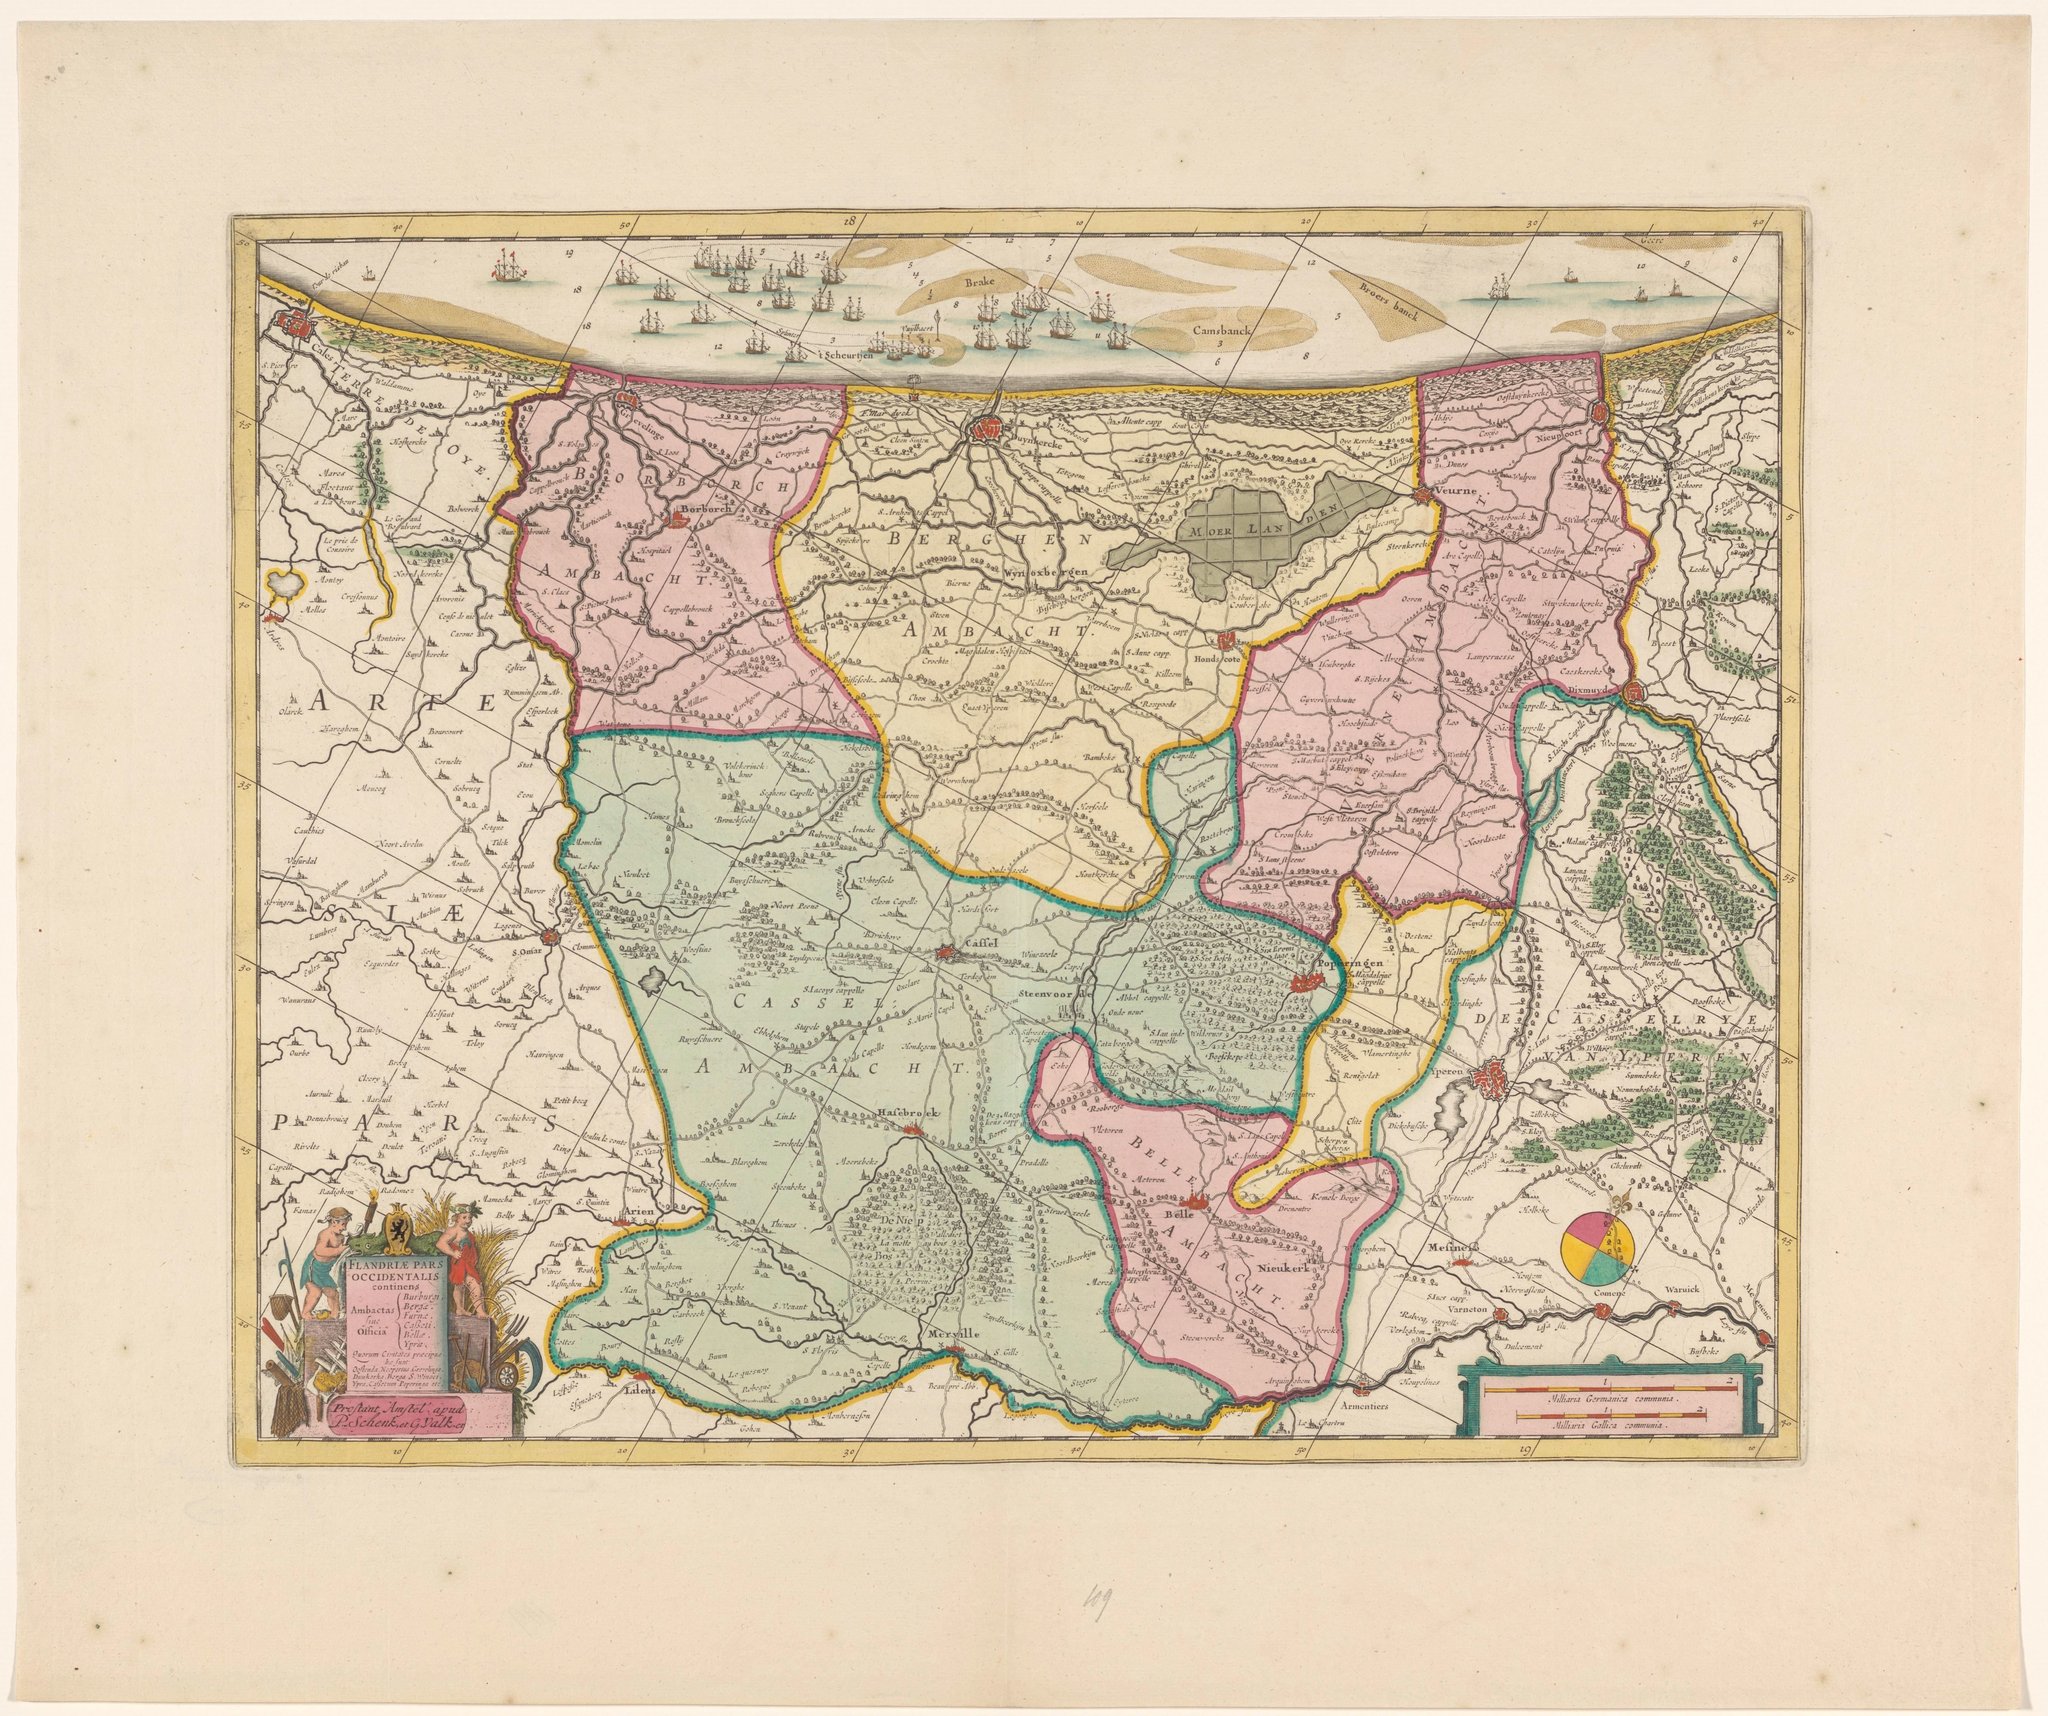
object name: map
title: Kaart van het westelijk deel van Vlaanderen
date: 1633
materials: paper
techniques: engraving, etching, hand coloring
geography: amsterdam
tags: maps of separate countries or regions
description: Kaart van het westelijk deel van Vlaanderen. Linksonder de titelcartouche, met bovenin het wapen van Vlaanderen. Rechtsonder een cartouche met twee schaalstokken: 2 Milliaria Germanica communia / 2 Milliaria Gallica communia. De kaart is voorzien van een coördinaten-net en een gradenverdeling langs de randen.